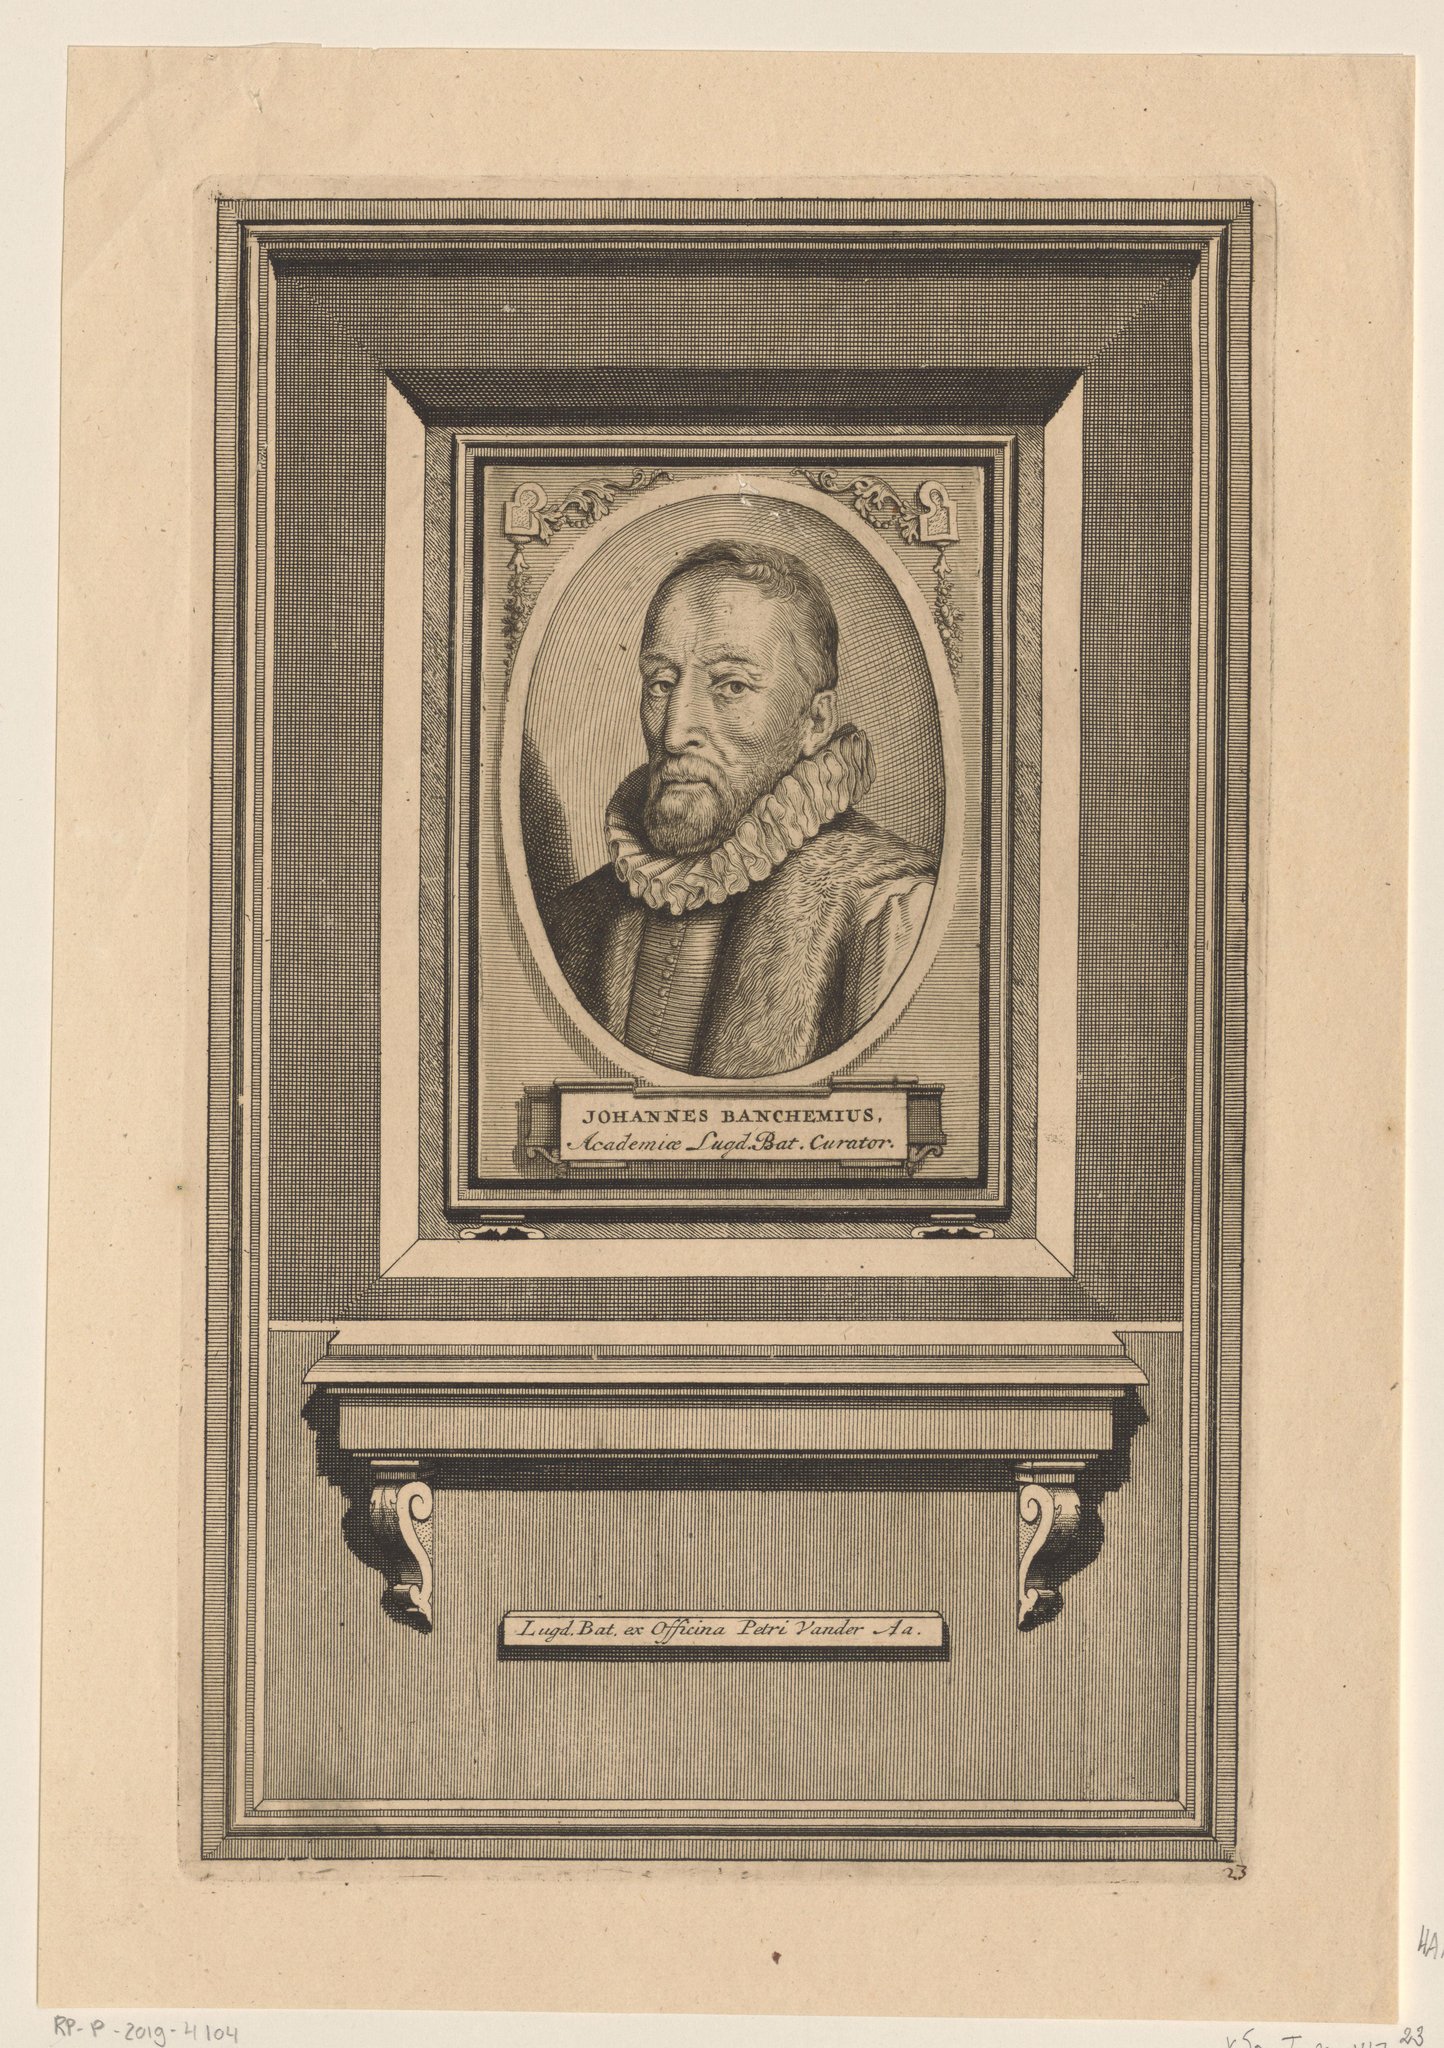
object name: print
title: Beroemde mannen aan de universiteit van Leiden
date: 1716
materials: paper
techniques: engraving, etching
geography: leiden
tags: leiden, historical persons